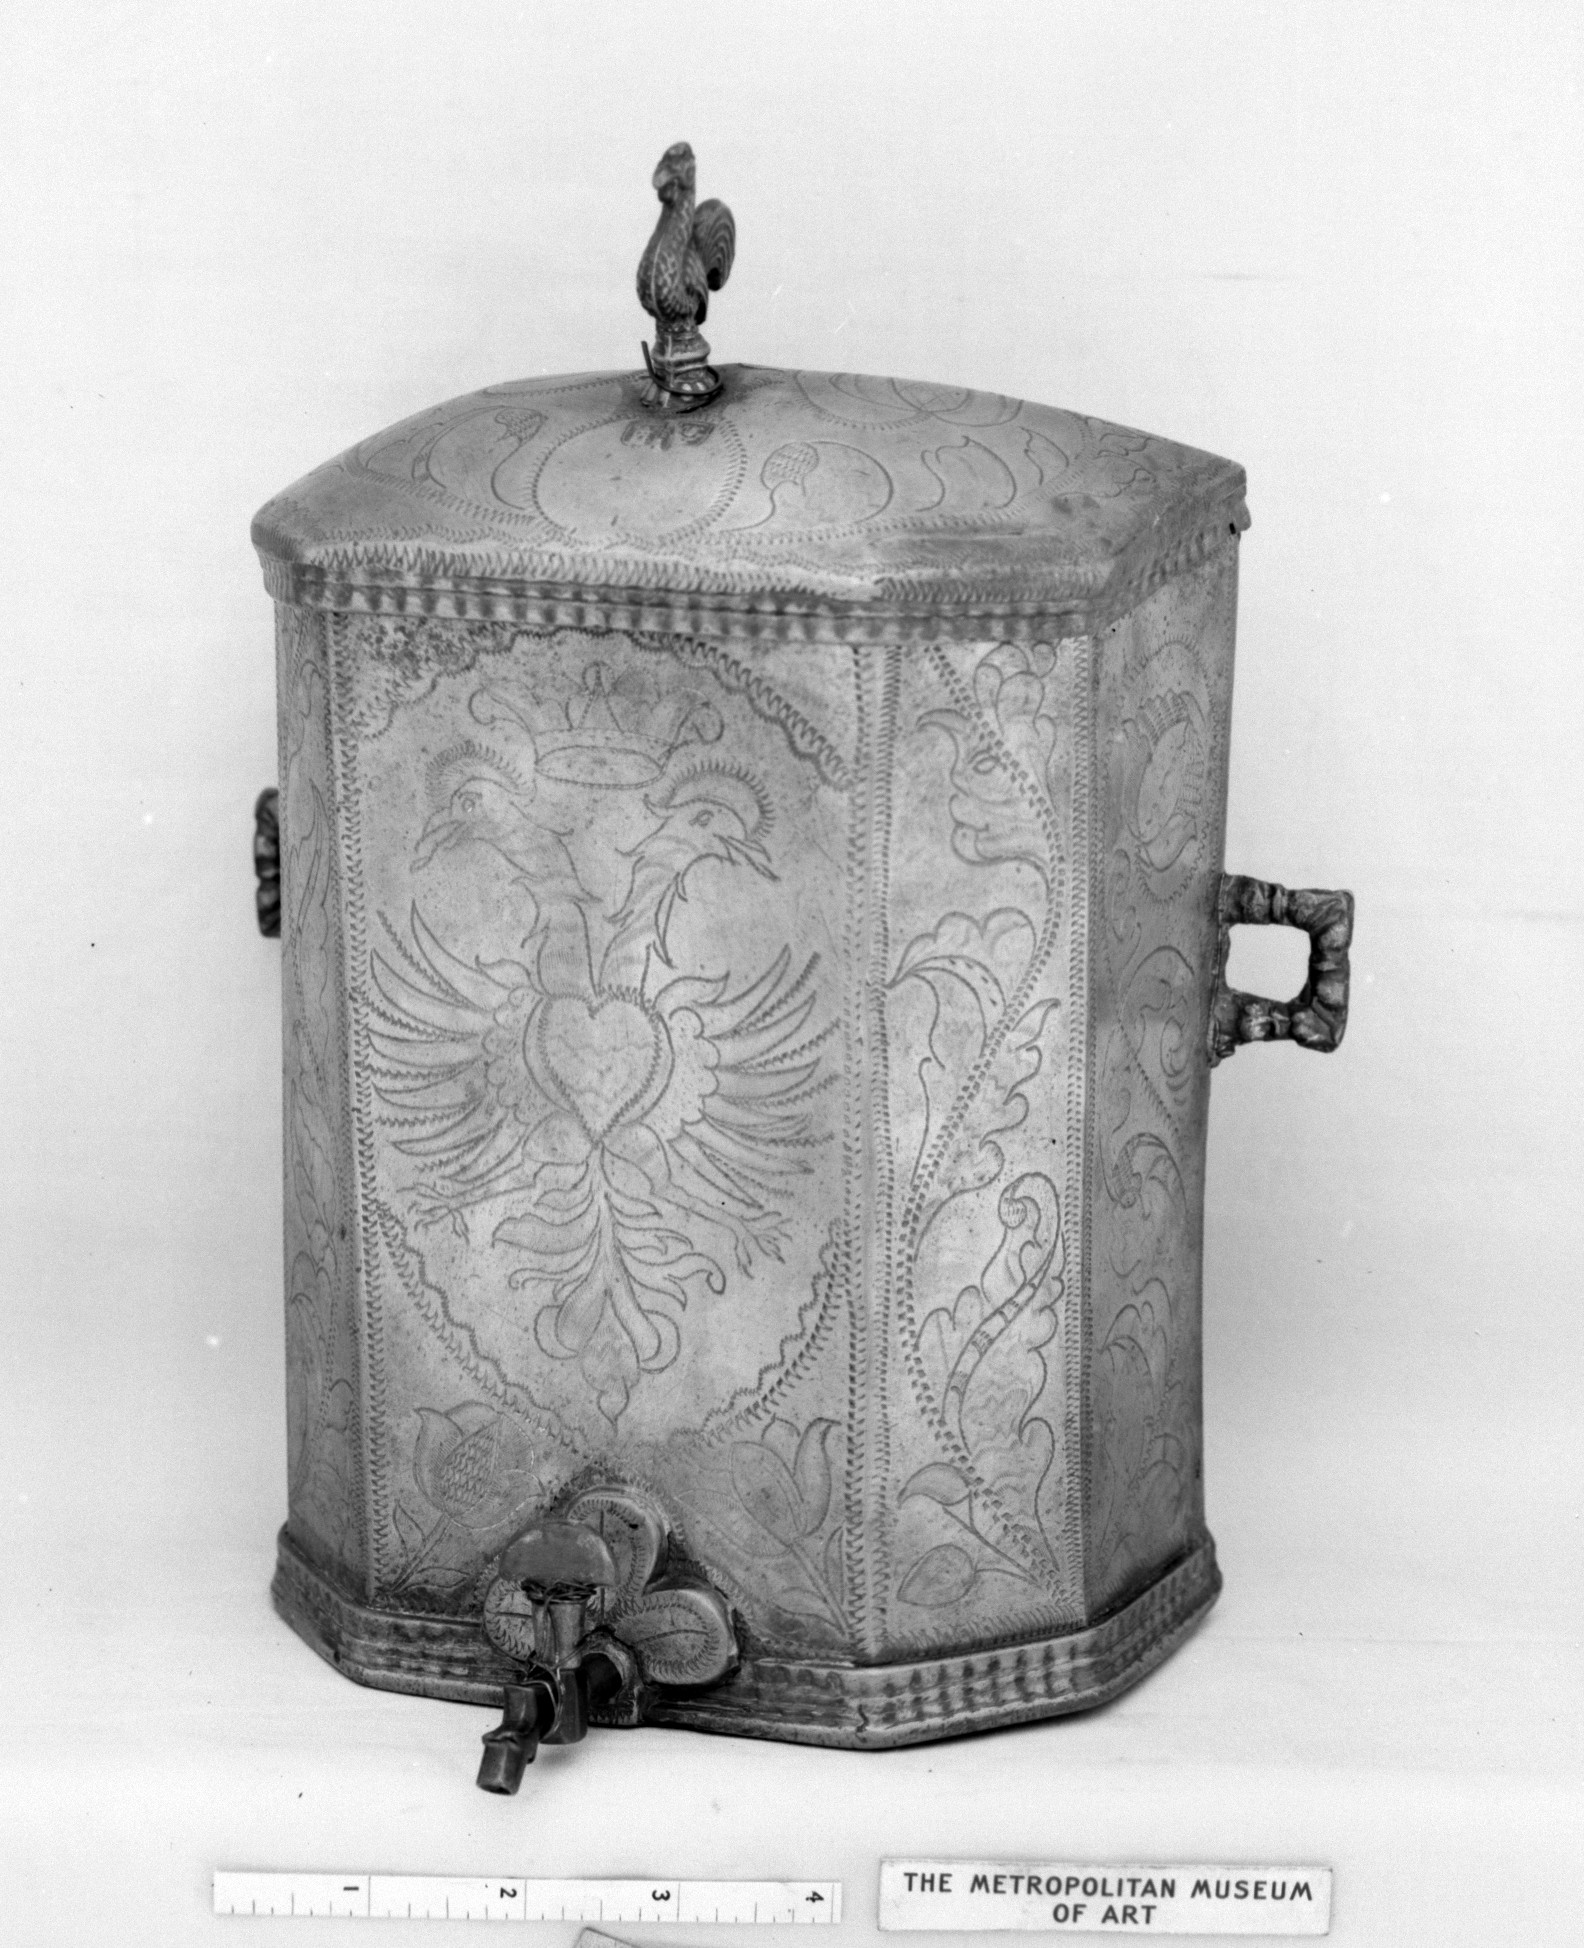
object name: lavatory or portable cistern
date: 1601-1700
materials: pewter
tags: eagles,coat of arms